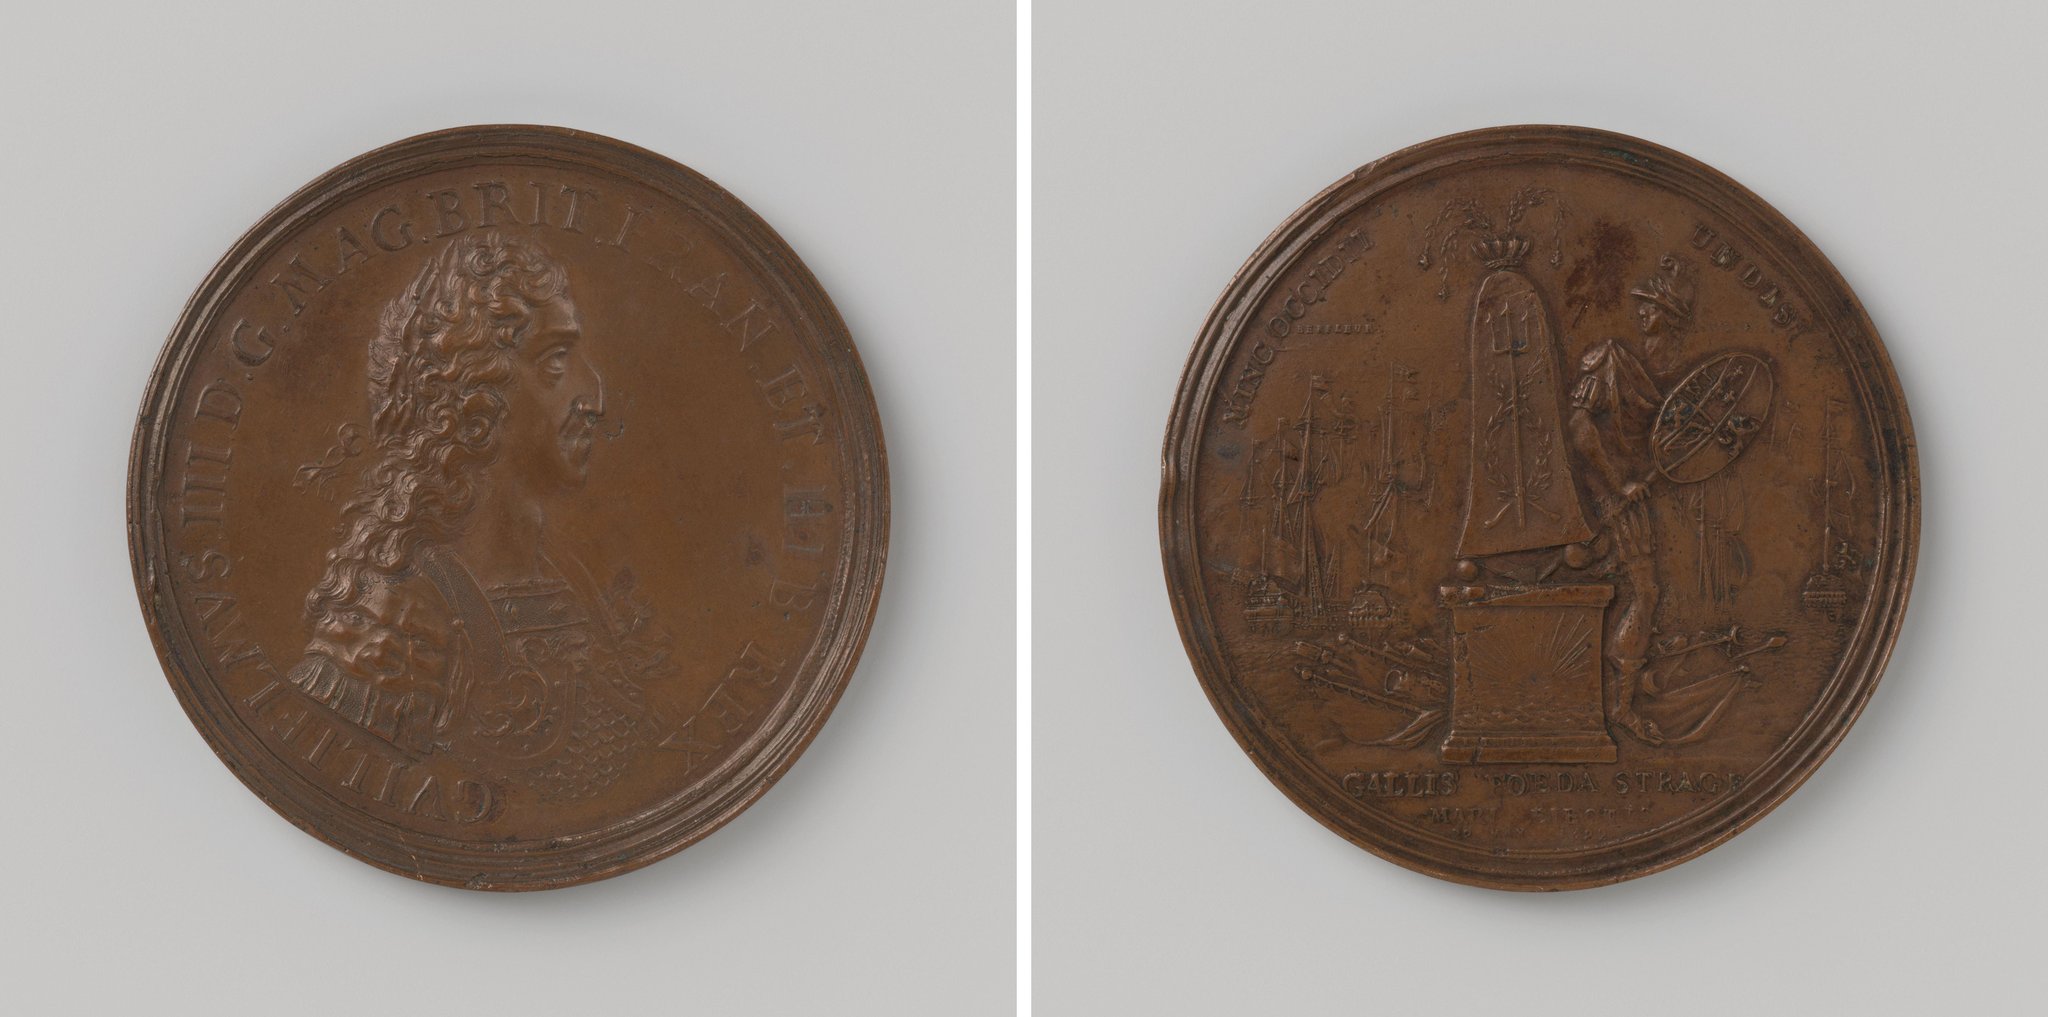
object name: copy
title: Zeeslag bij Kaap La Hogue, de Fransen verslagen door de vloot van Engeland en Holland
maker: jan luder (i)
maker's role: medailleur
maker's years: 1648-1719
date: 1692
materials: bronze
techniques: striking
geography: amsterdam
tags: william iii (prince of orange and king of england, scotland, and ireland)